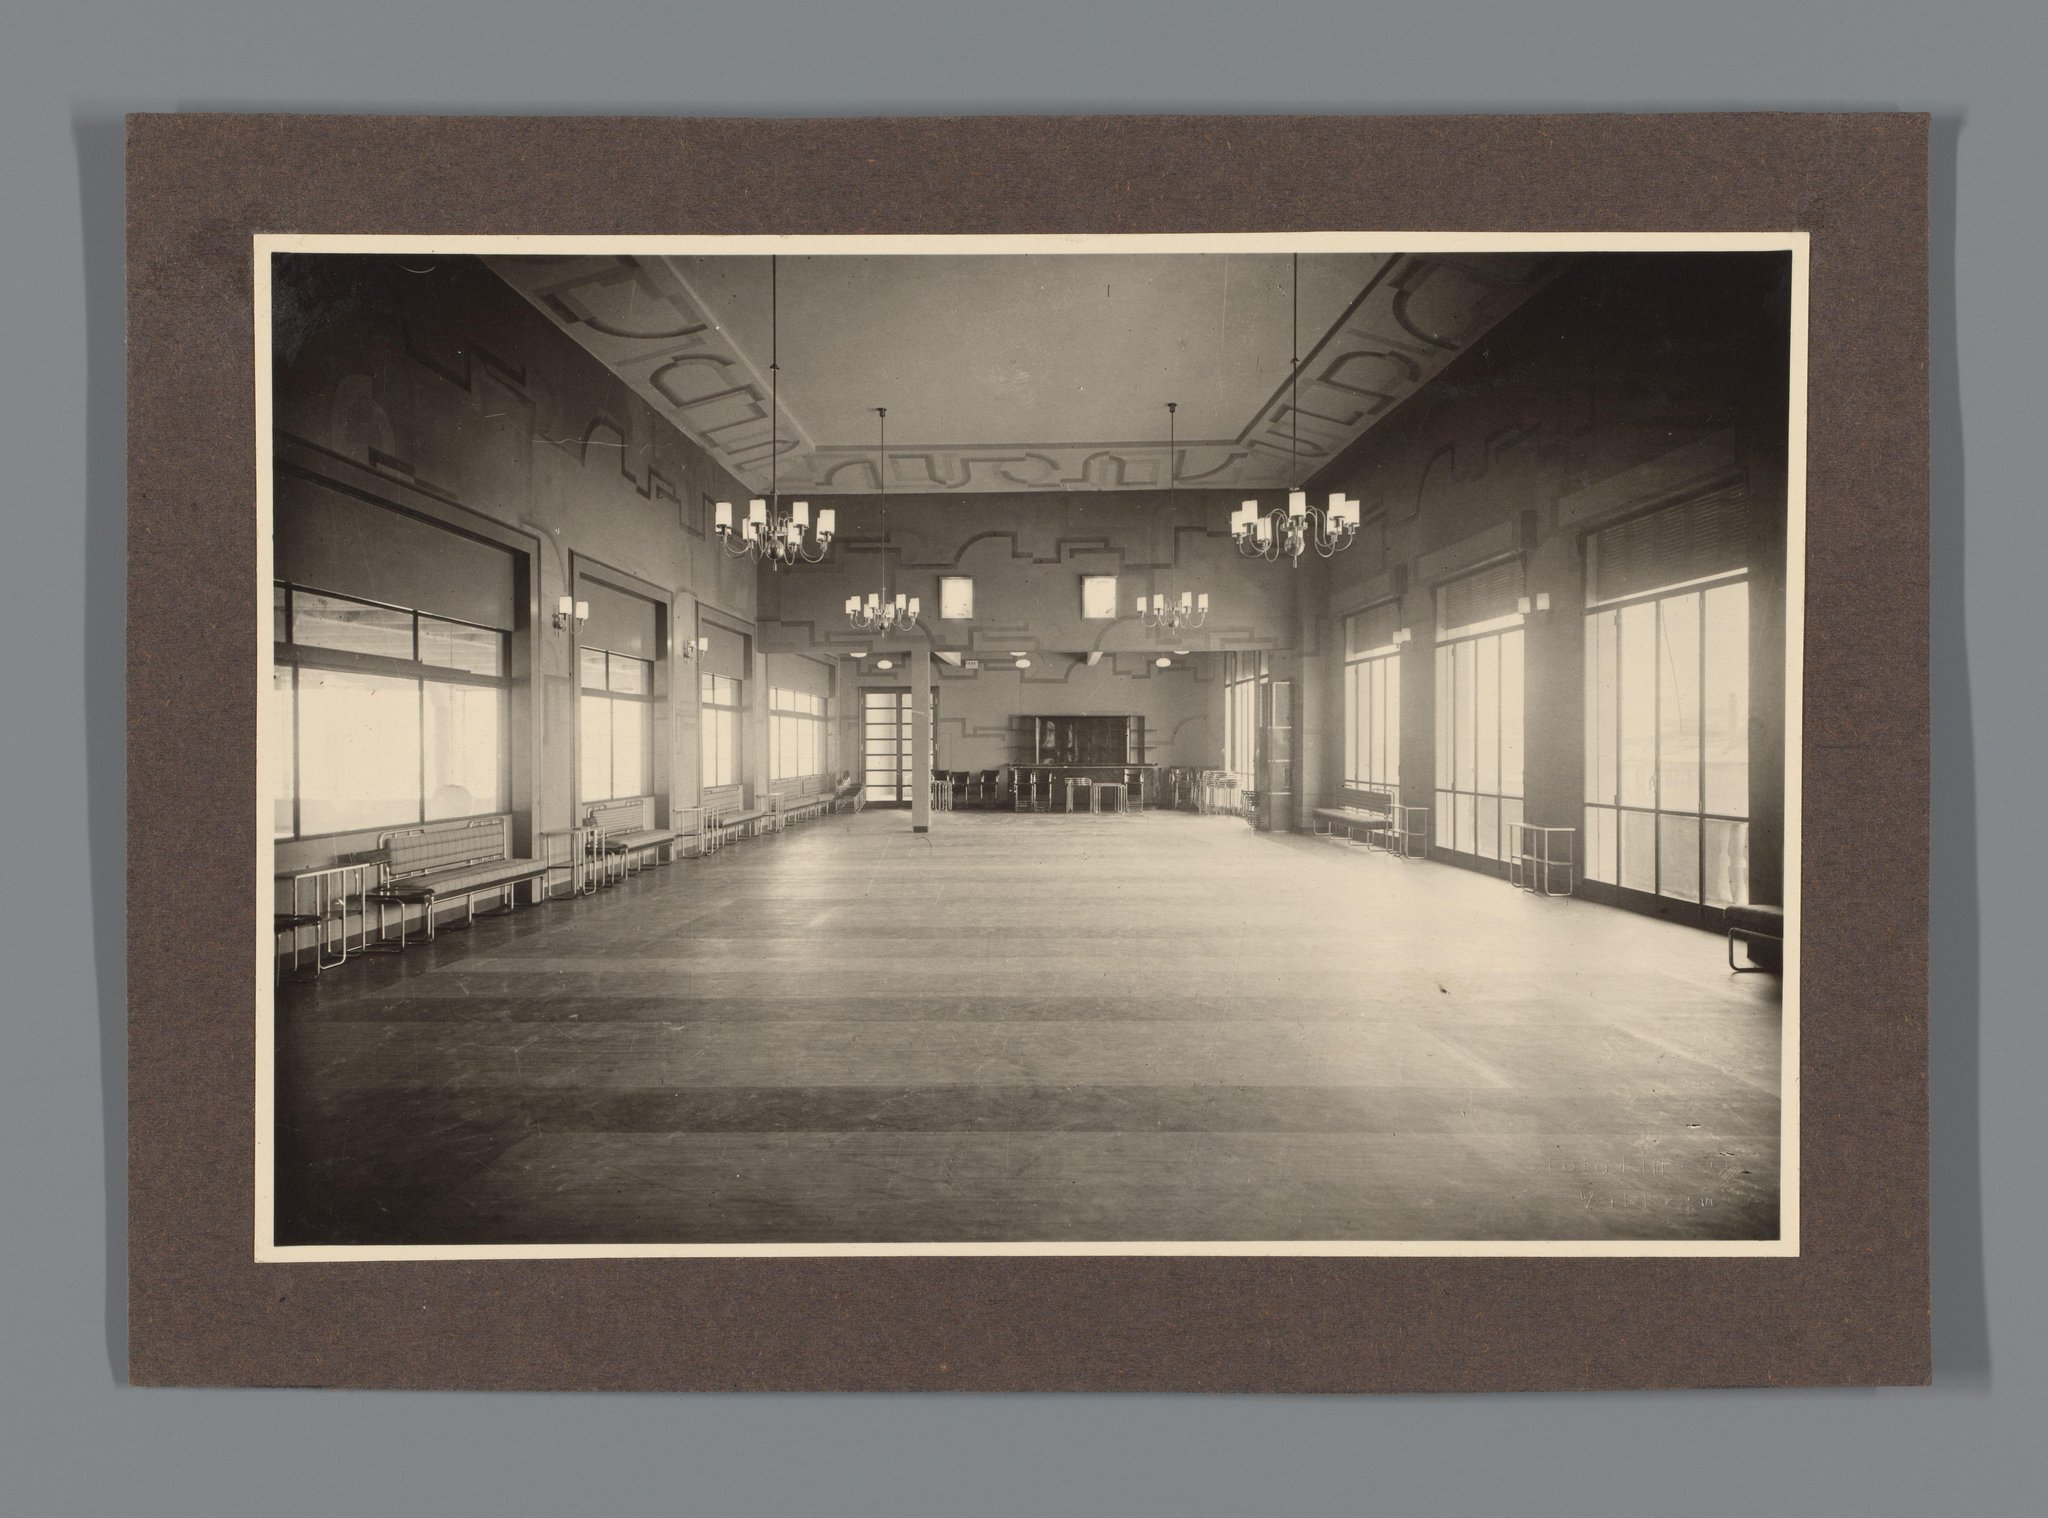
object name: photograph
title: Italië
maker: Anonymous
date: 1880-1910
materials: photographic support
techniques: albumen print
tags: italy